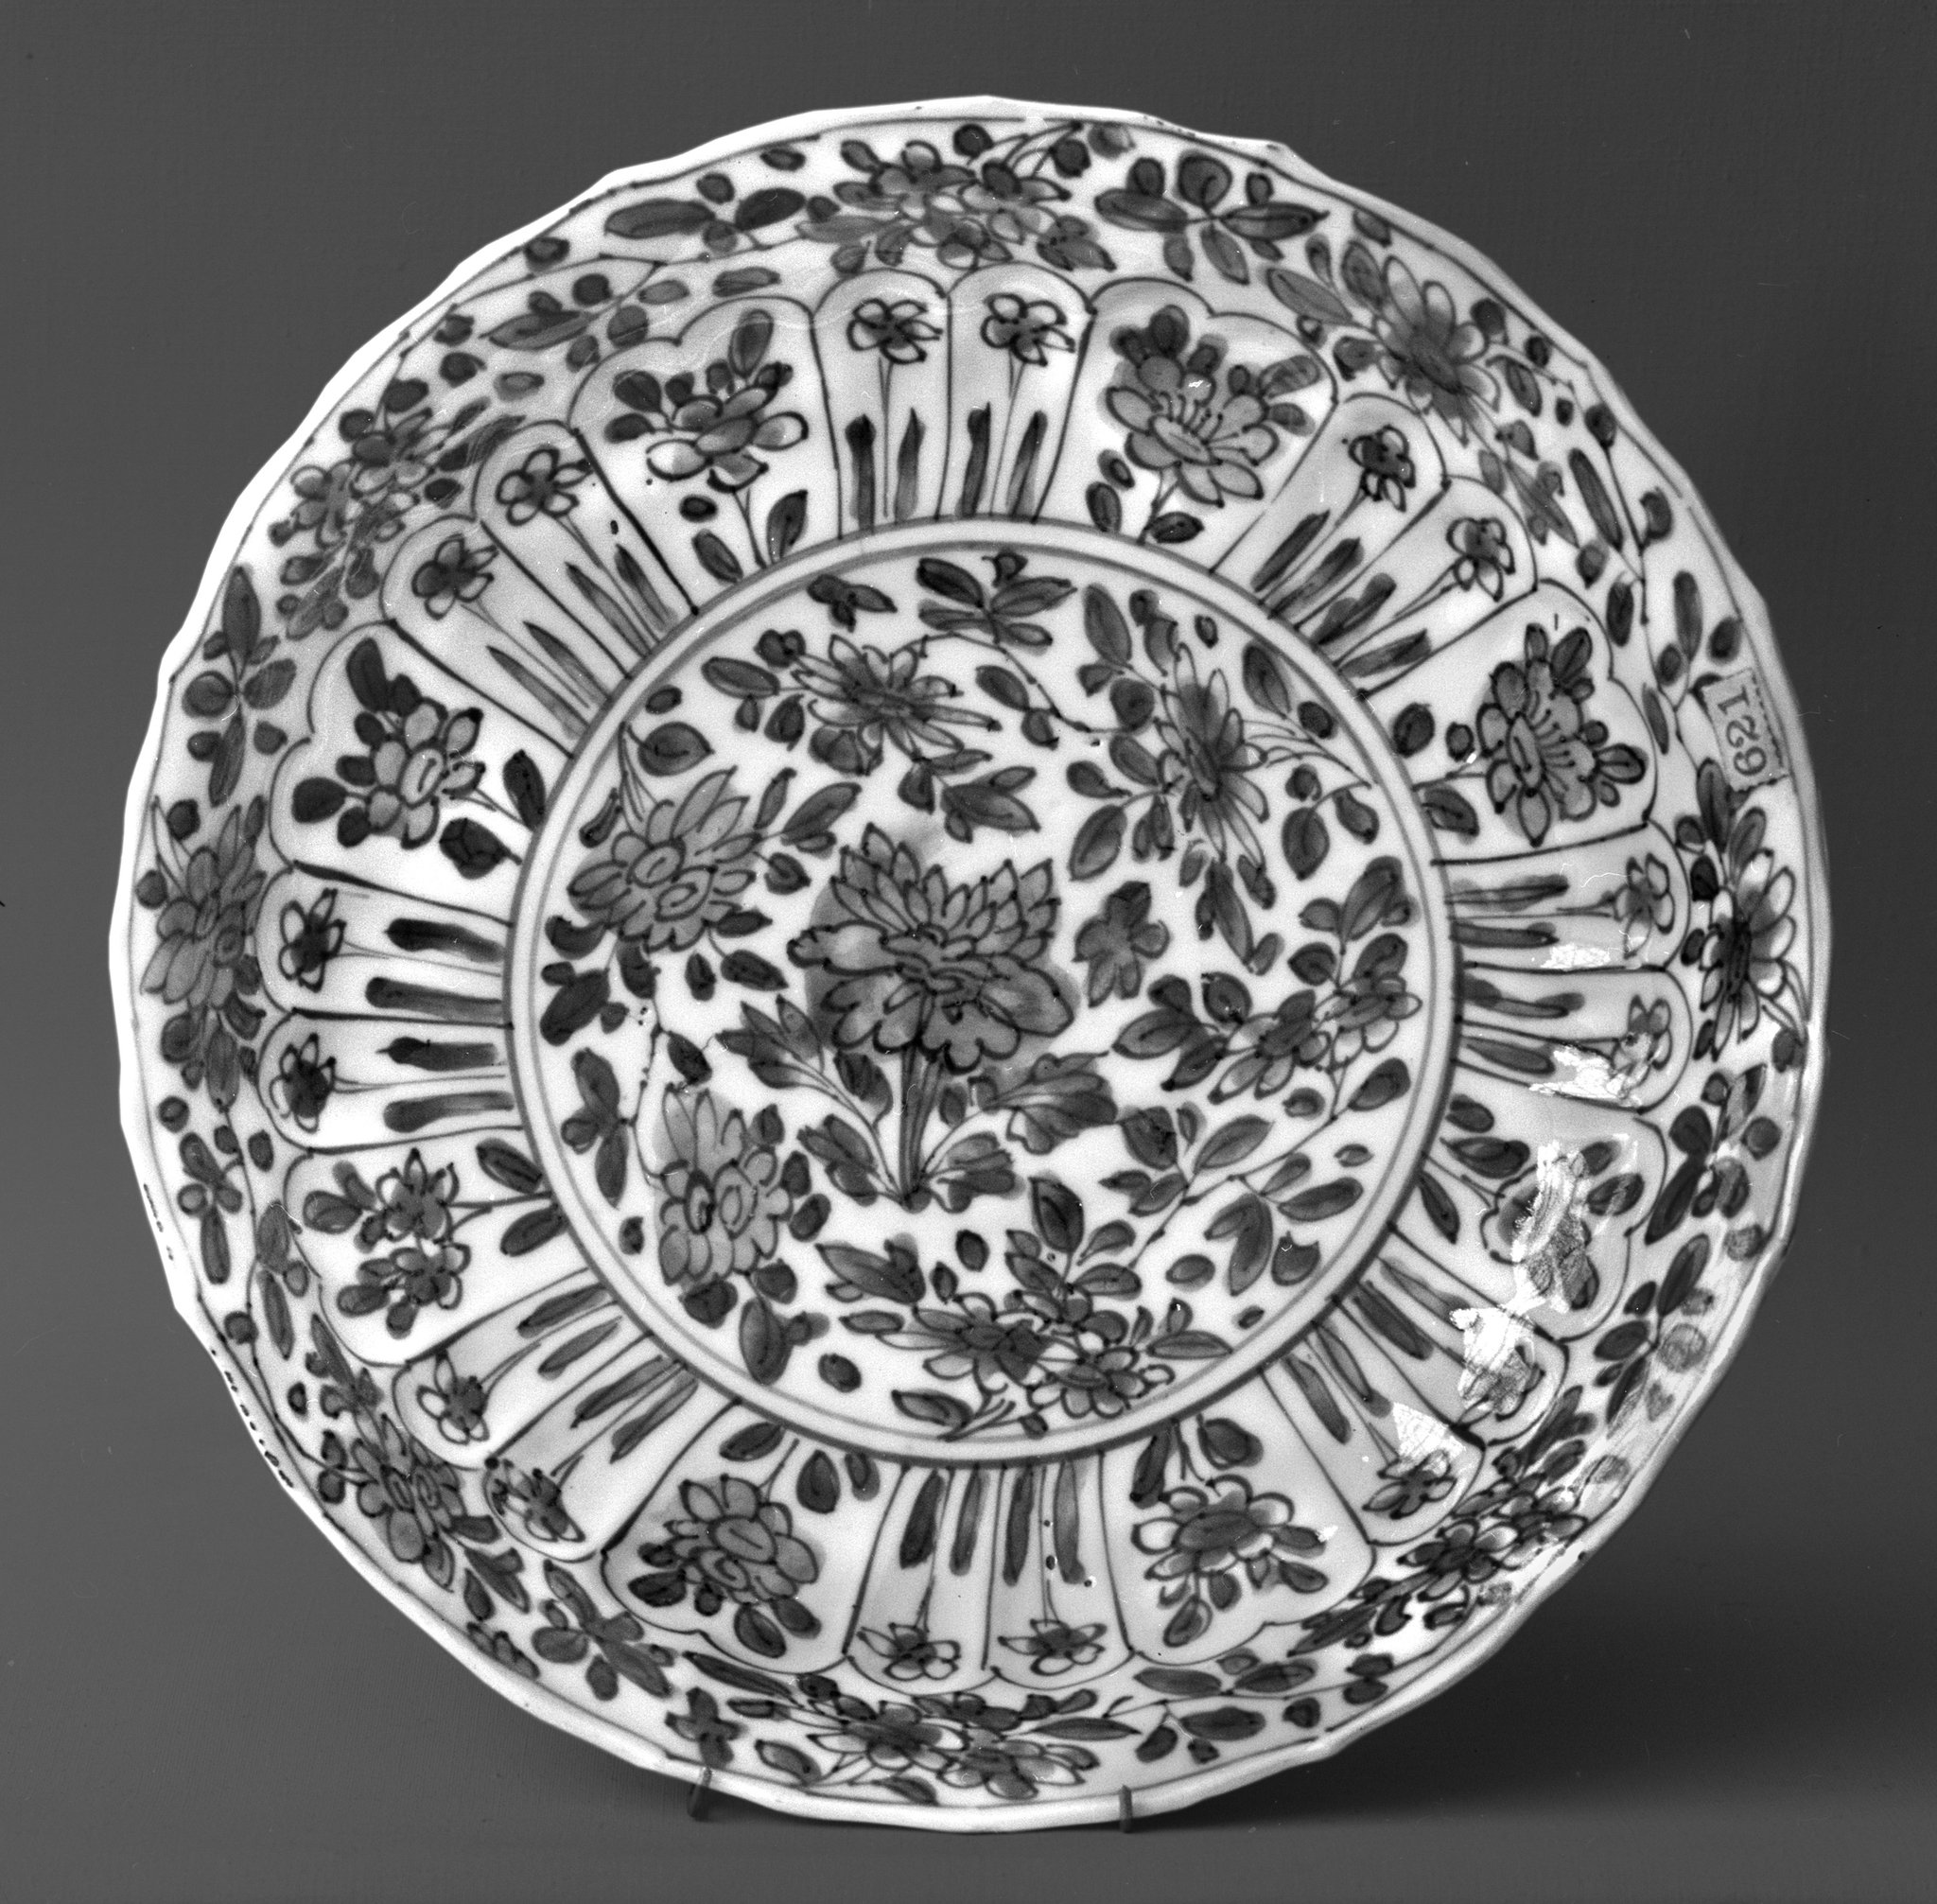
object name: dish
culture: chinese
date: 1667-1733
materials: porcelain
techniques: painting, underglaze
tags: flowers